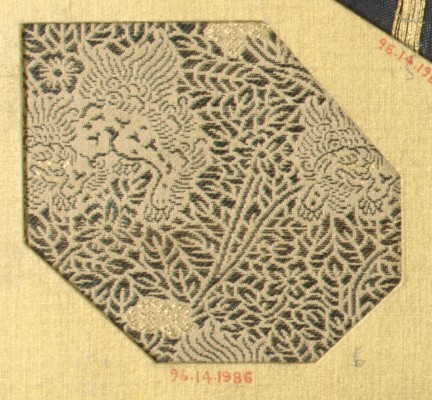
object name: piece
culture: japanese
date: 1701-1900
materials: silk